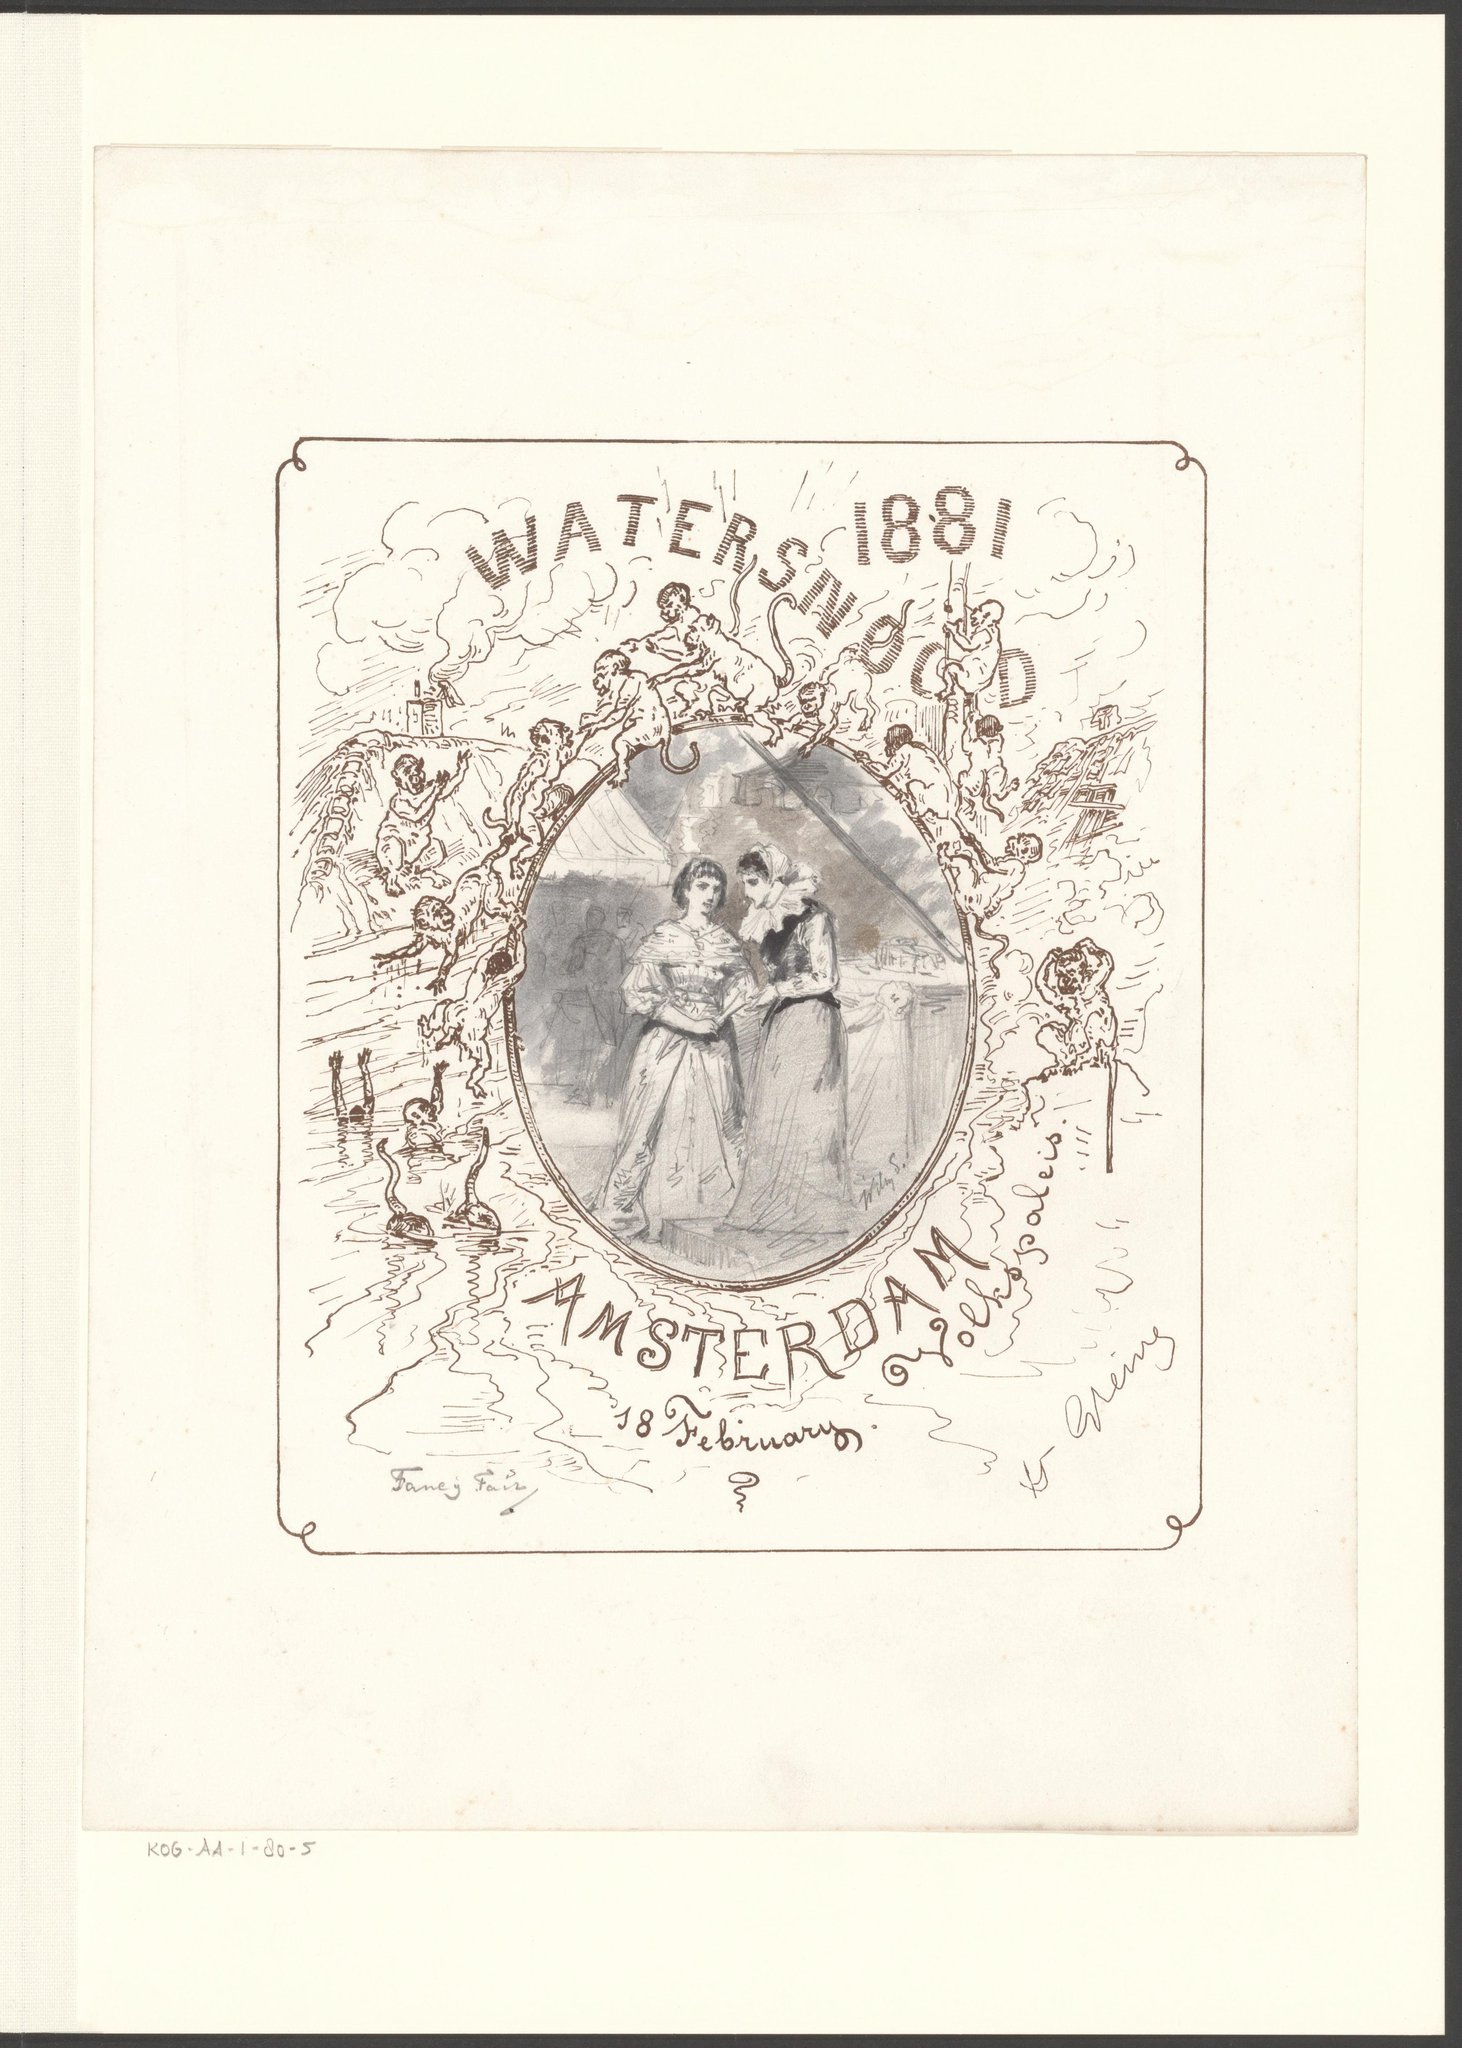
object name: drawing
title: Twee dames op de fancy-fair in het Paleis voor Volksvlijt ten bate van de slachtoffers van de watersnood van 18 februari 1881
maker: johan conrad greive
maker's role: draughtsman, painter, print maker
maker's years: 1837-1891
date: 1881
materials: ink, paper, pencil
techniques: brush, lithograph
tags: flood, poster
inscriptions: signature: ‘Wilm S.’, inscription: ‘in [...] 2001 bij k[...] ingesneden / en gerestaureerd’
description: Onderwerpsrubriek binnen de Atlas Amsterdam: 1881-1886.